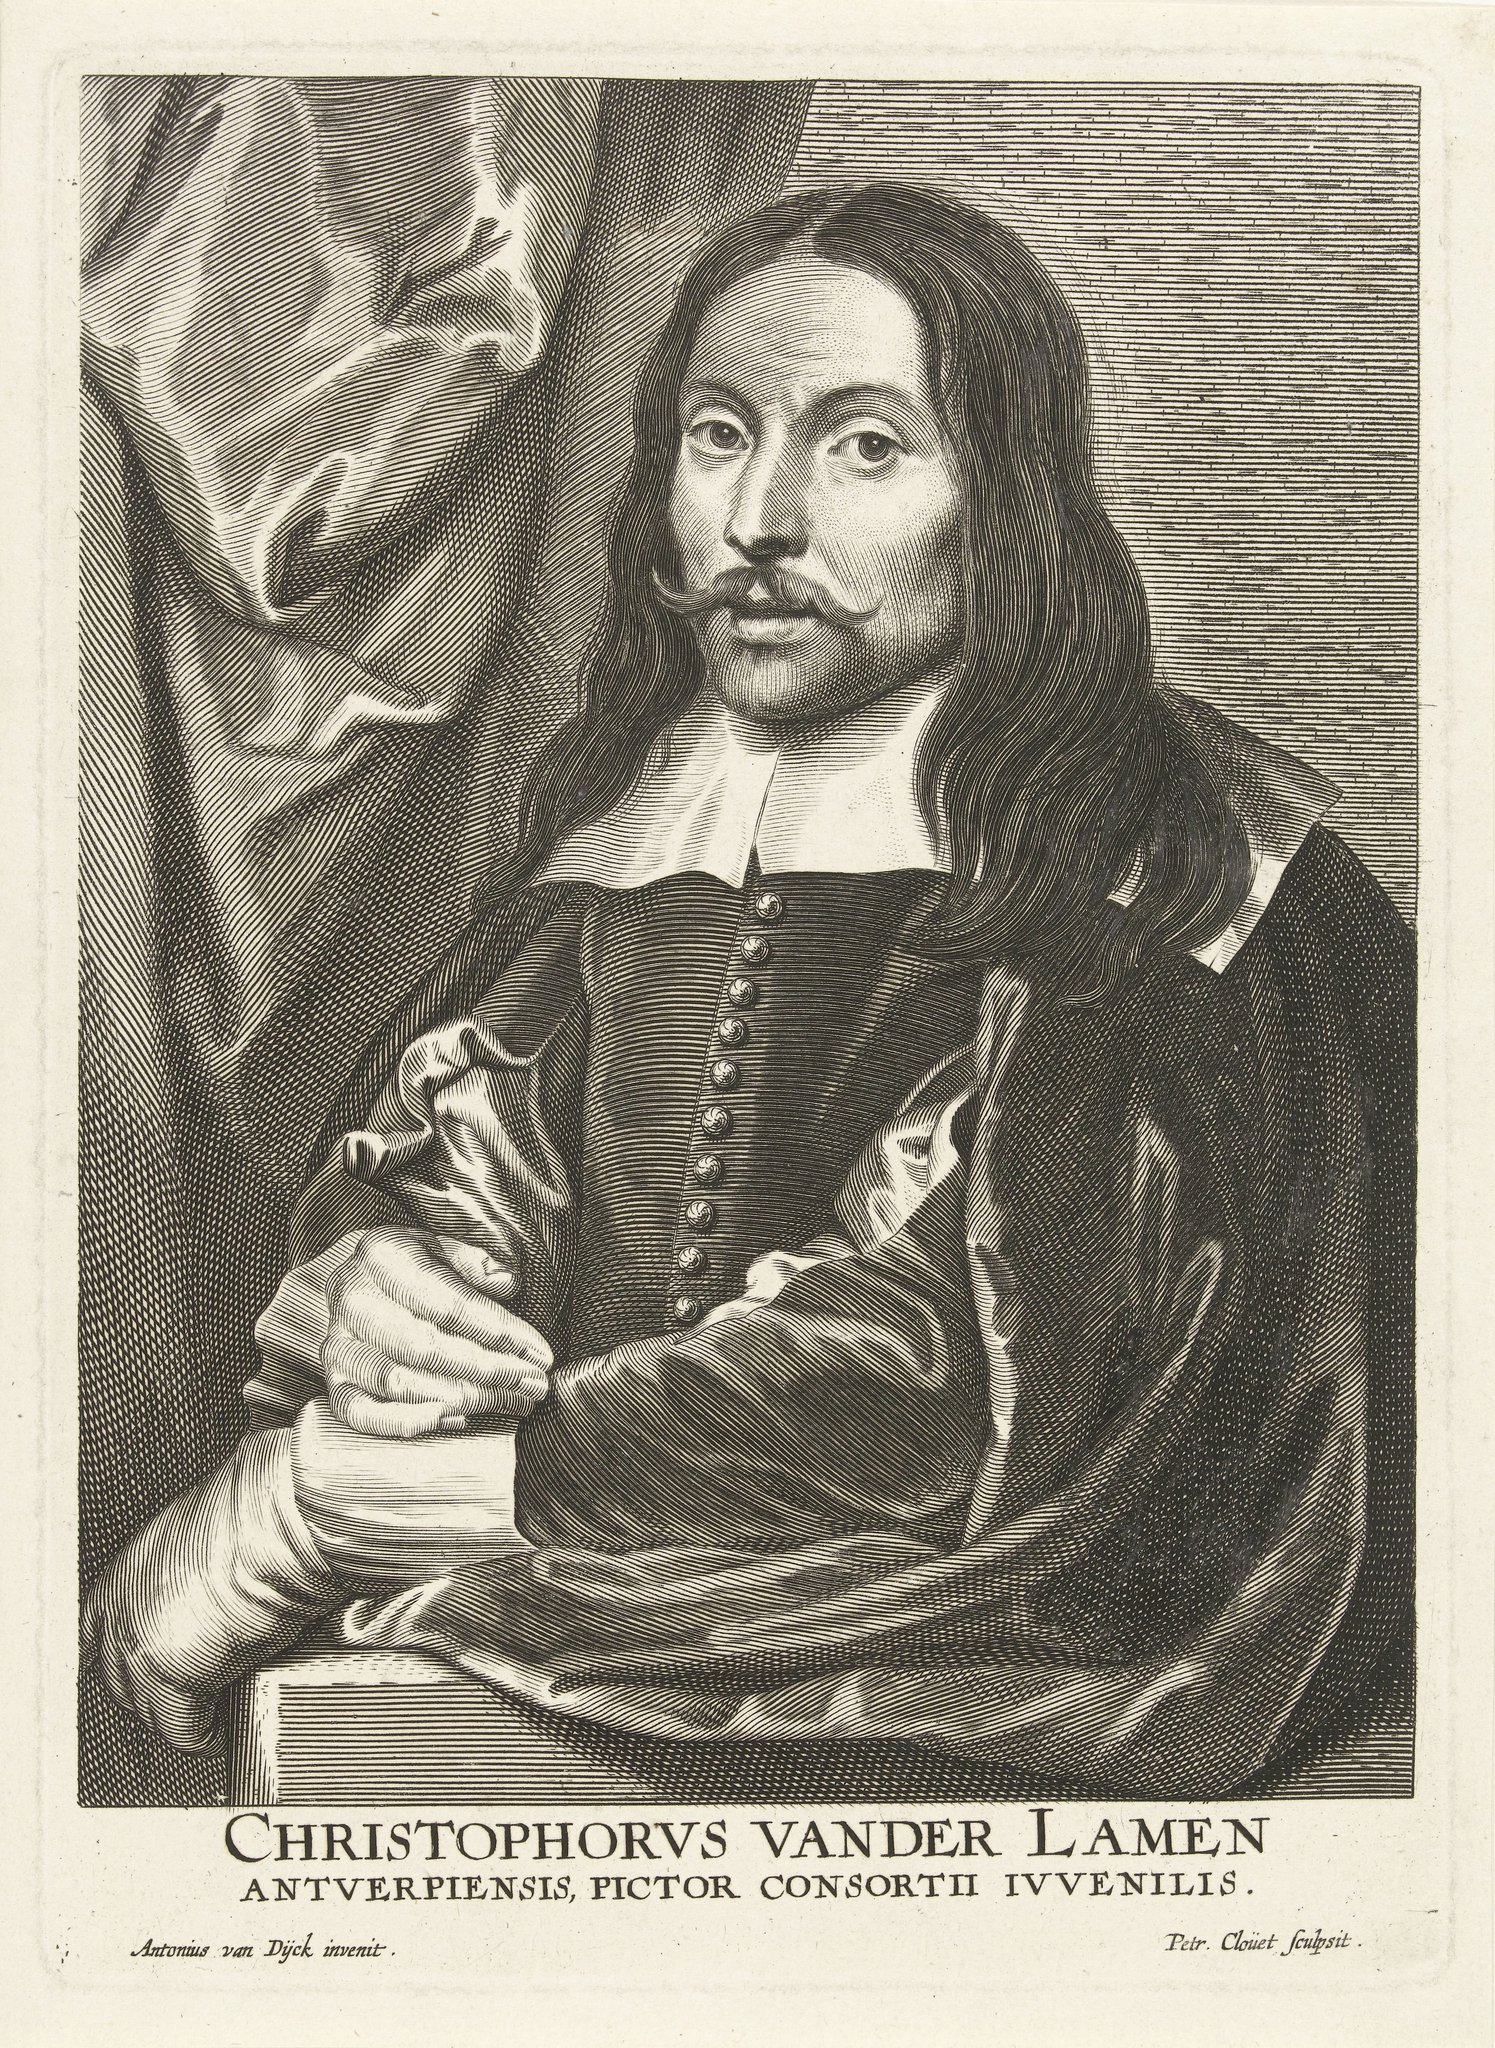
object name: print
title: Portret van Christoffel Jacobsz. van der Laemen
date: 1639-1670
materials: paper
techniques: engraving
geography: antwerp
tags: painter, christoffel van der lamen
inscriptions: collector's mark: Lugt 2228, collector's mark: Lugt 2166, collector's mark: Lugt 2760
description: Portret van schilder Christoffel Jacobsz. van der Laemen. Buste naar links. De prent heeft een Latijns onderschrift.